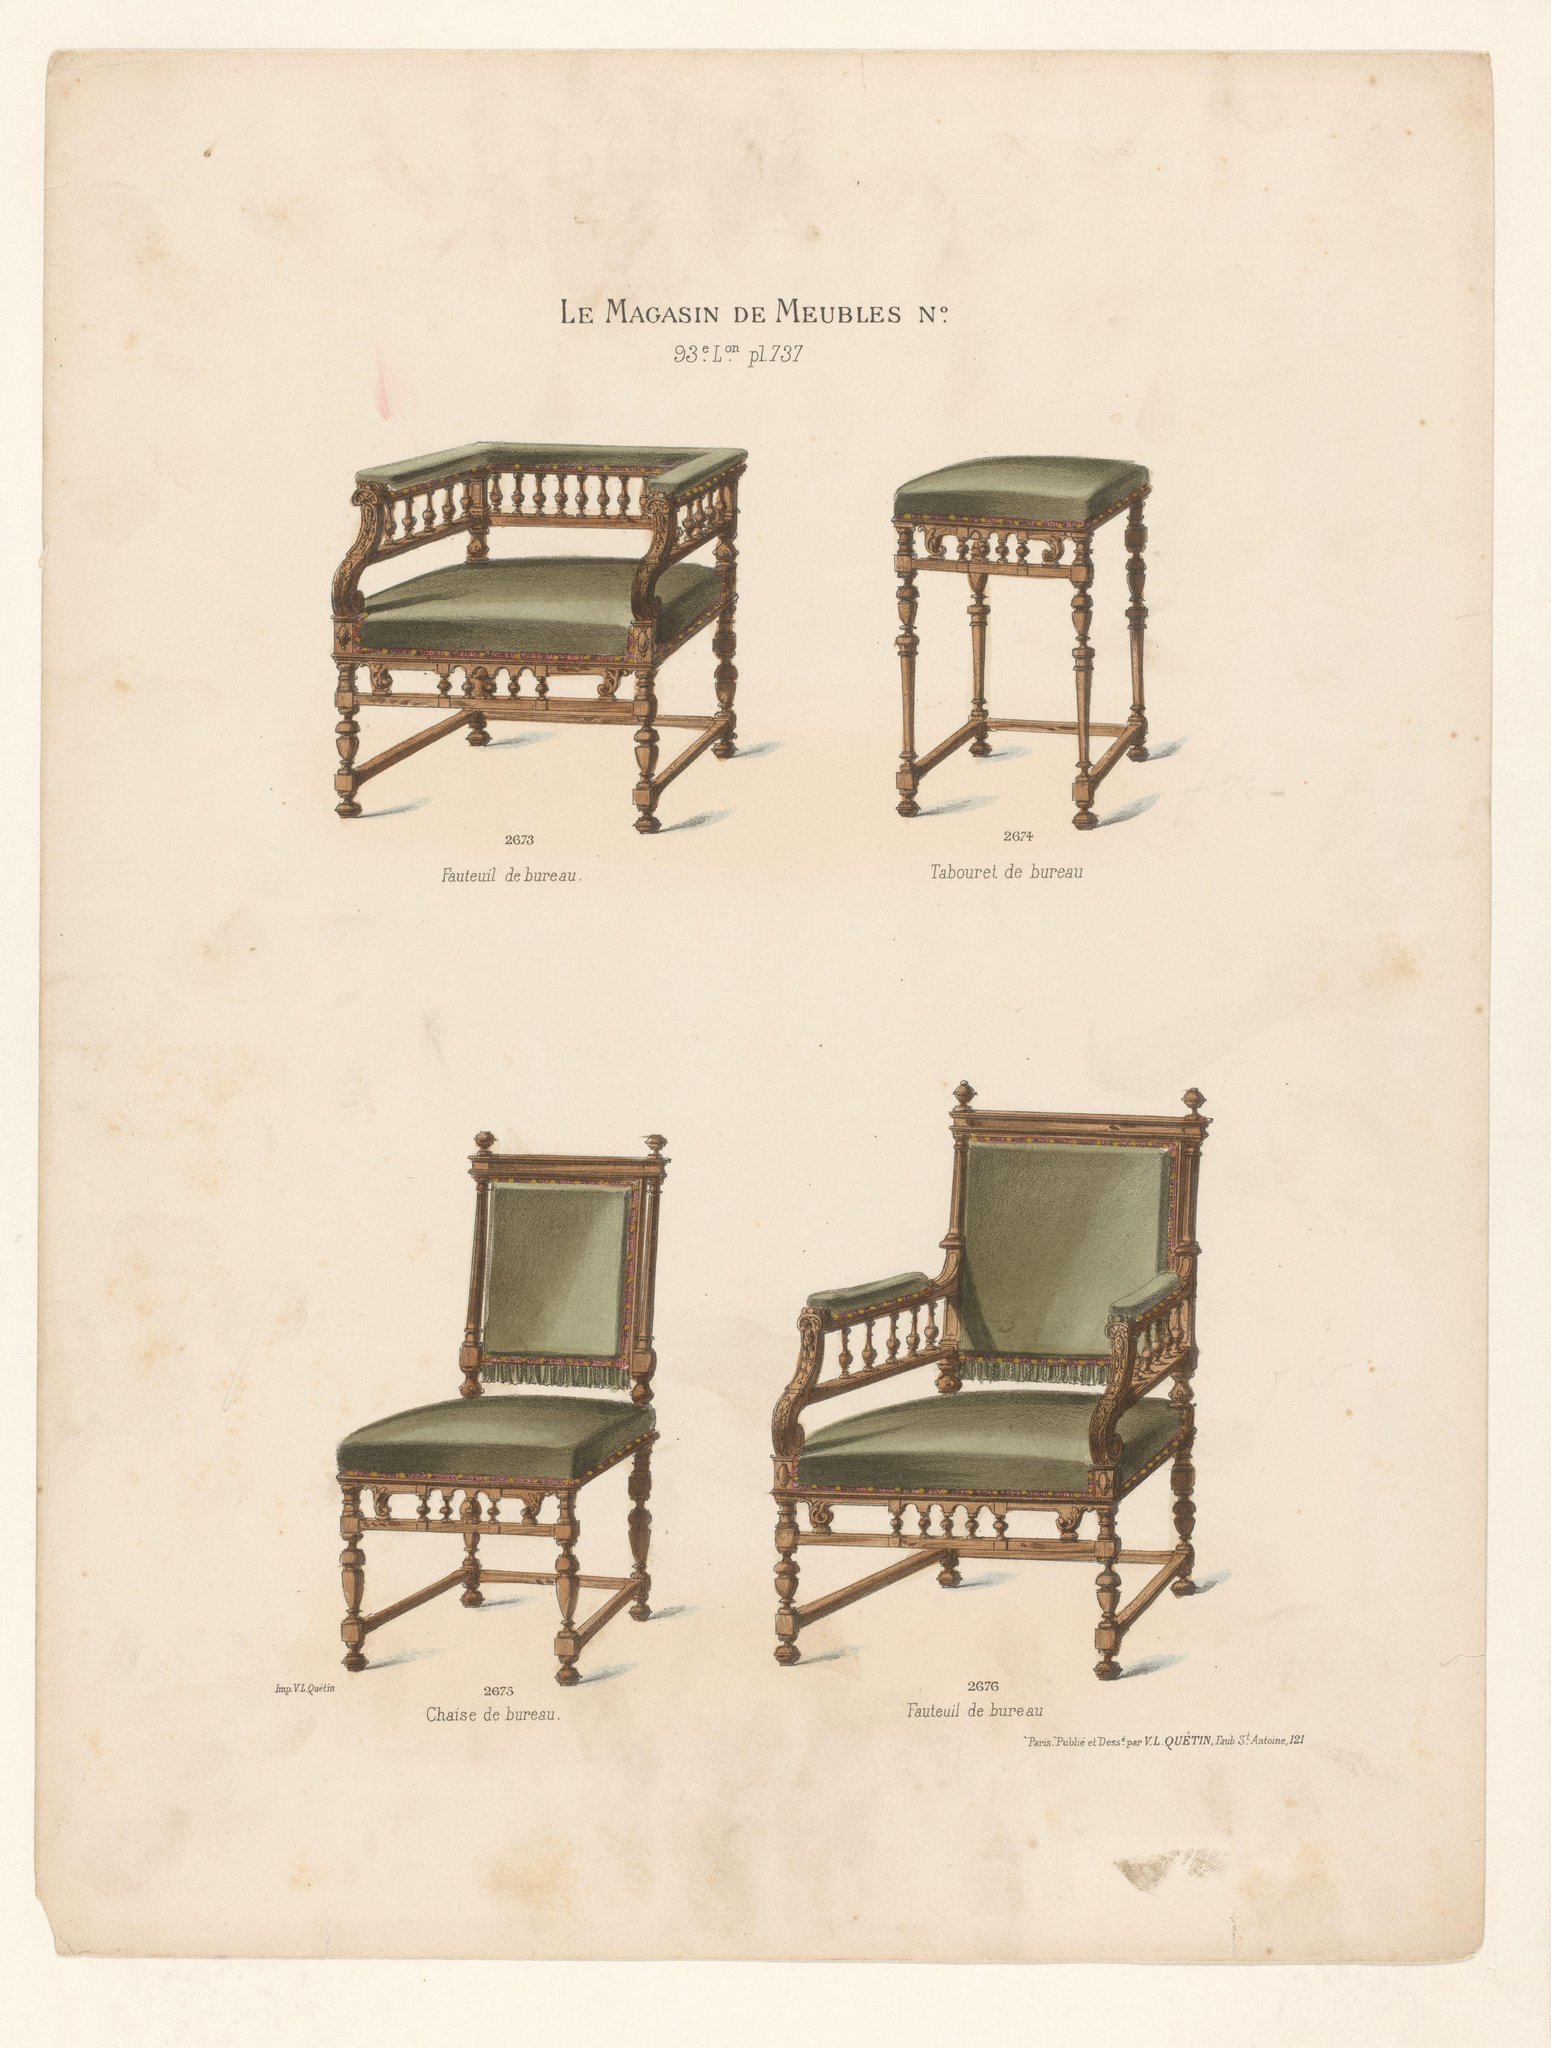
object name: print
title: Le Magasin de Meubles / No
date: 1878-1904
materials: paper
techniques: hand coloring, lithograph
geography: paris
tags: seating furniture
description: Drie bureaustoelen en een tabouret. Prent uit 93e Livraison.